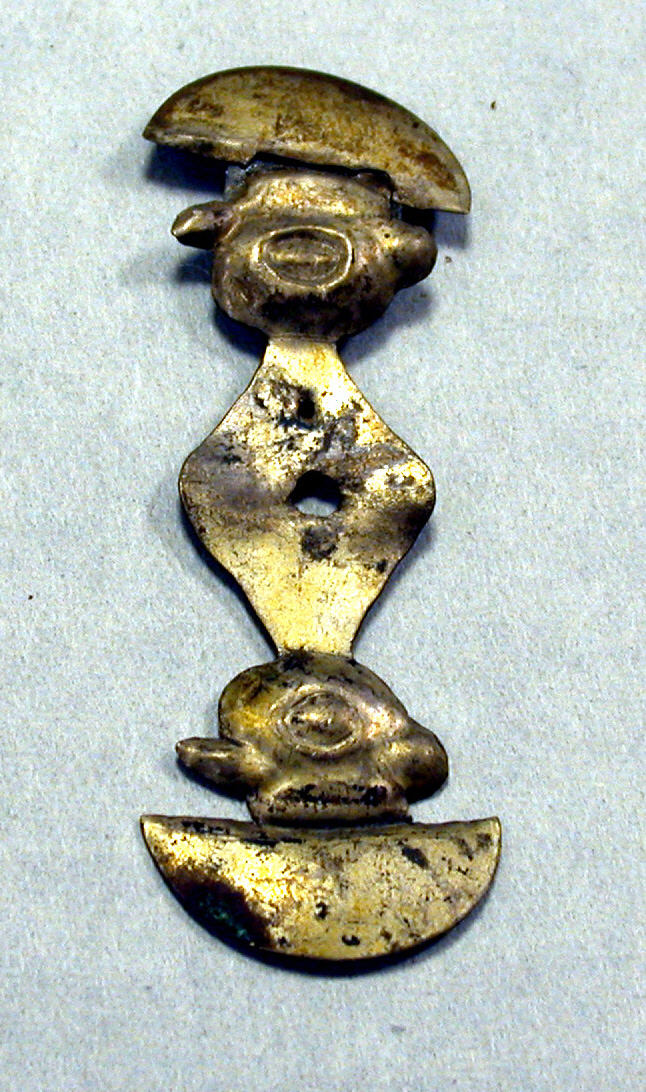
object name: tweezer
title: Hammered Silver Figure Ornament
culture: chancay or chimú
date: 1001-1500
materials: gilt, silver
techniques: hammering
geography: peru